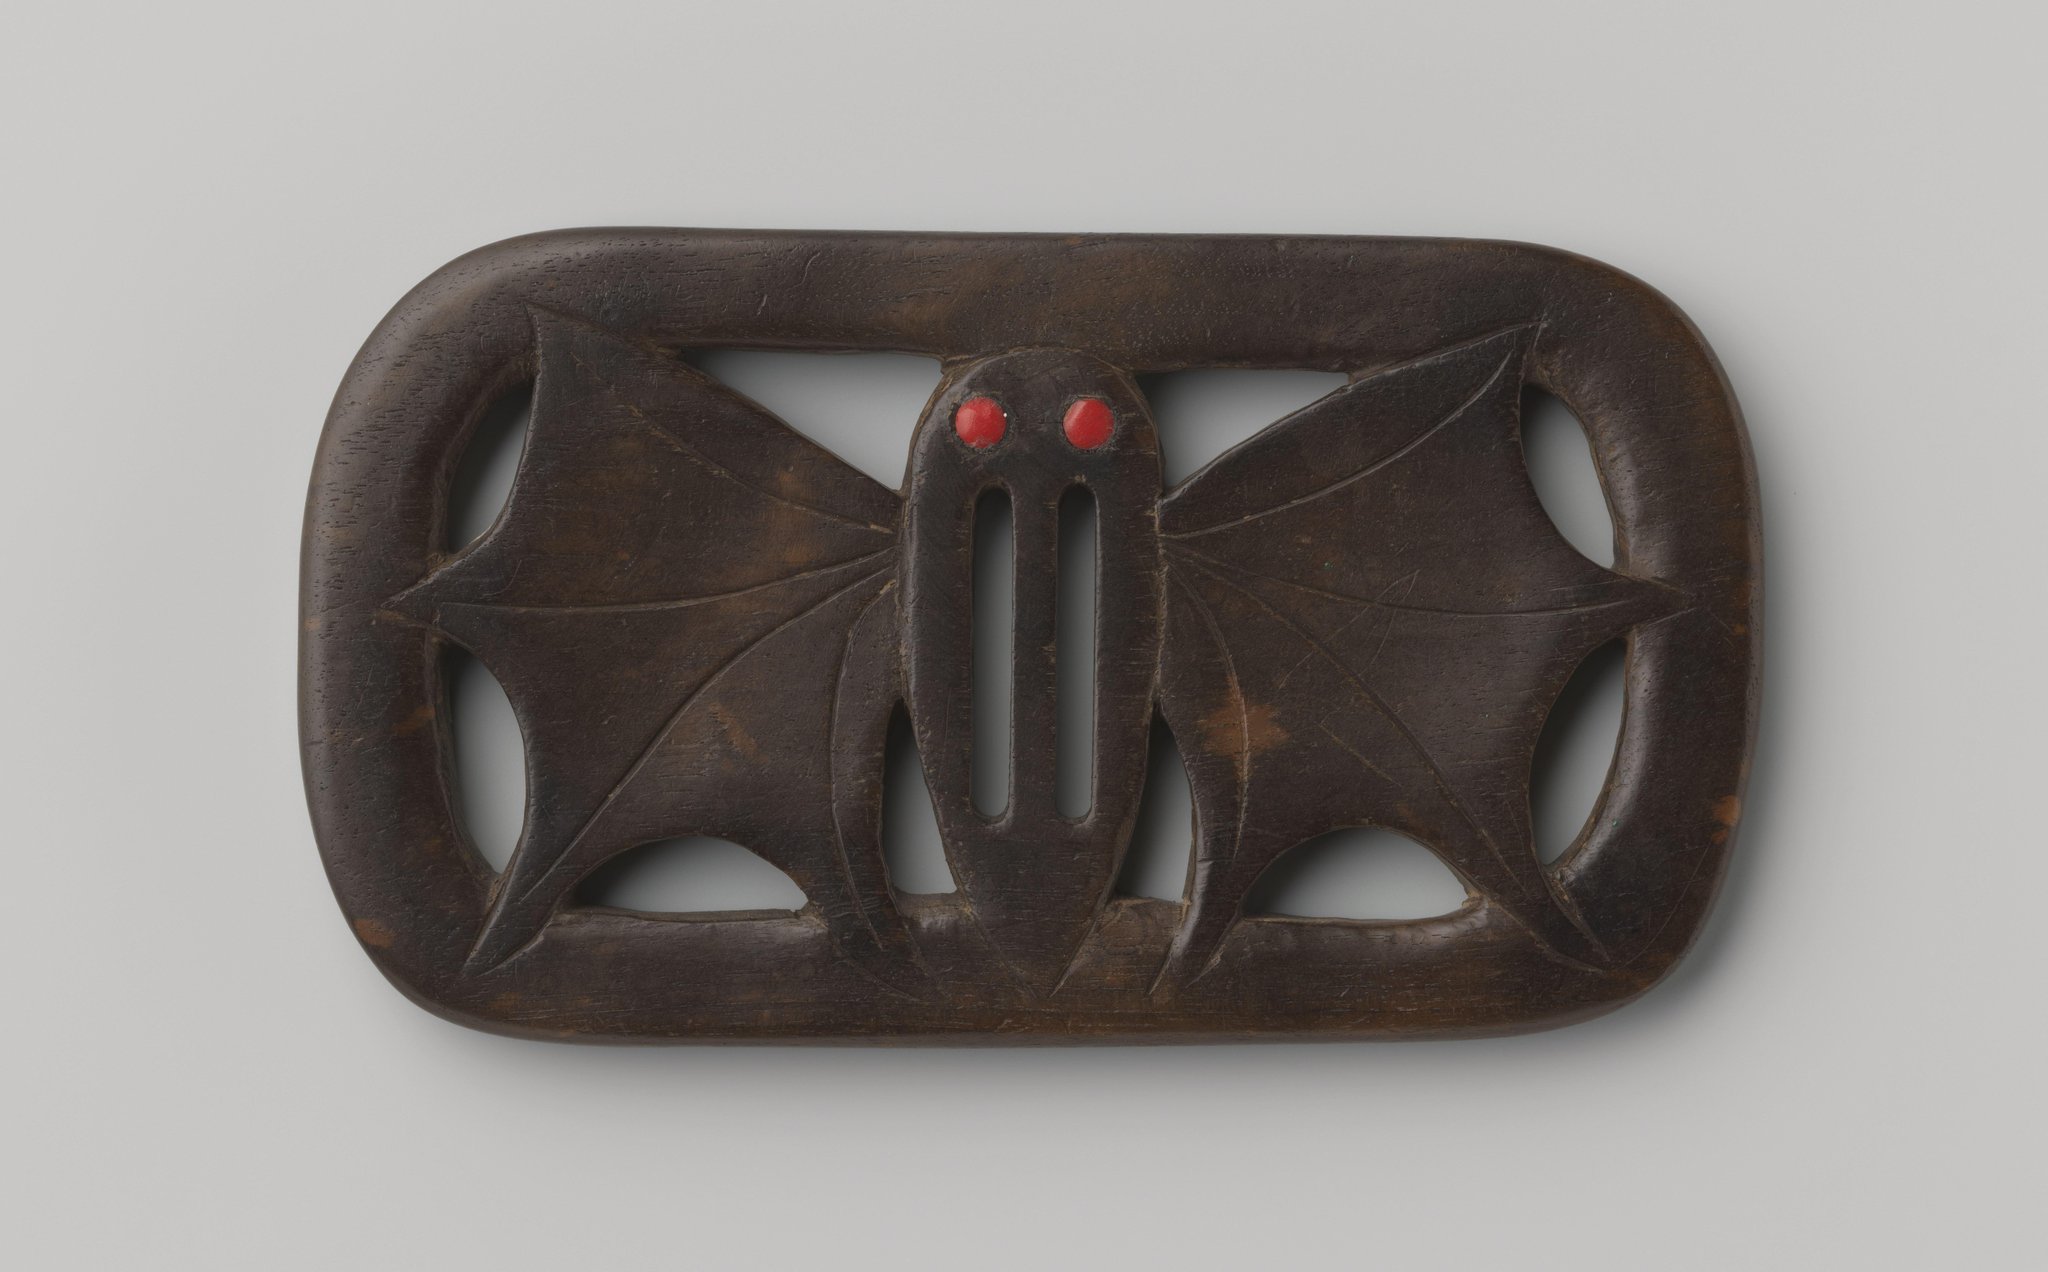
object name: buckle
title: Gesp 'Vleermuis'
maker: Anonymous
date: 1920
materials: paste, wood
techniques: cutting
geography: amsterdam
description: Houten gesp 'Vleermuis', met twee ogen van rode paste. De gesp is niet gesigneerd.